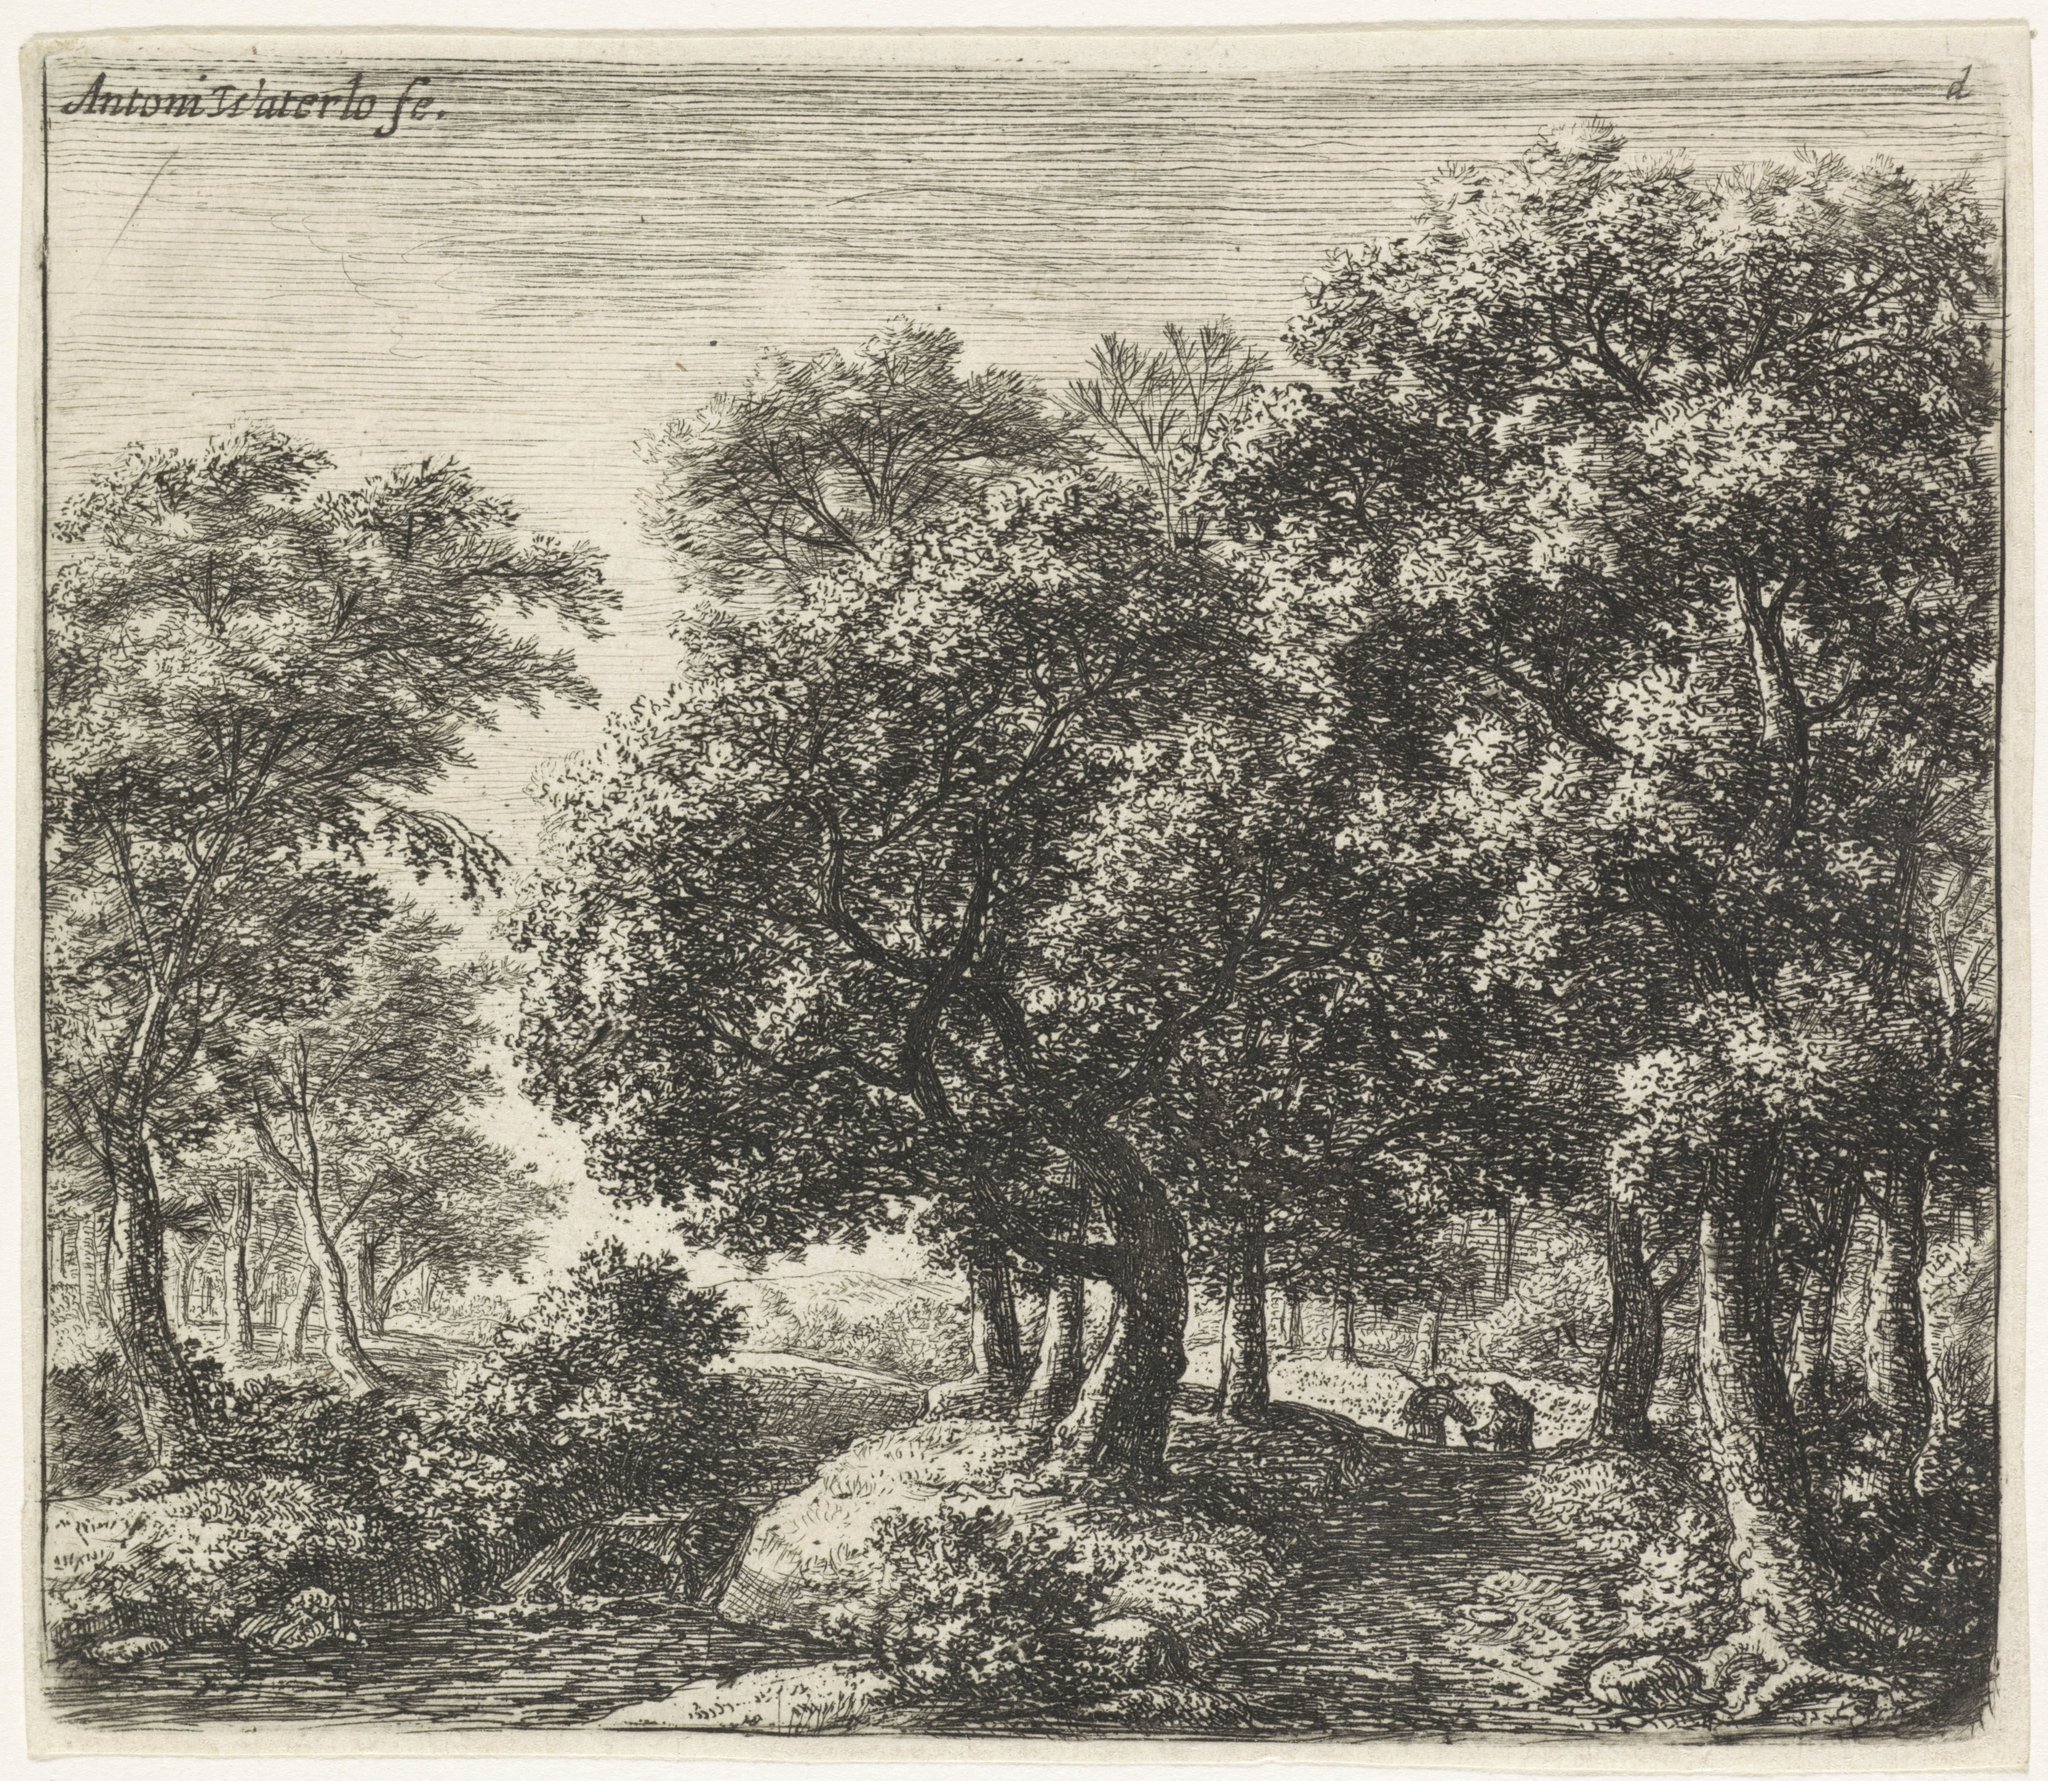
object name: print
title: Beboste landschappen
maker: anthonie waterloo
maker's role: draughtsman, painter, print maker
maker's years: 1609-1690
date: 1630-1663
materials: paper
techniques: etching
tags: brook, forest path or lane, landscapes (+ landscape with figures, staffage)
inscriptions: collector's mark: Lugt 240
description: Rechts lopen twee figuren op een bospad. Links stroomt een beek. Rechtsboven is de letter d weergegeven.